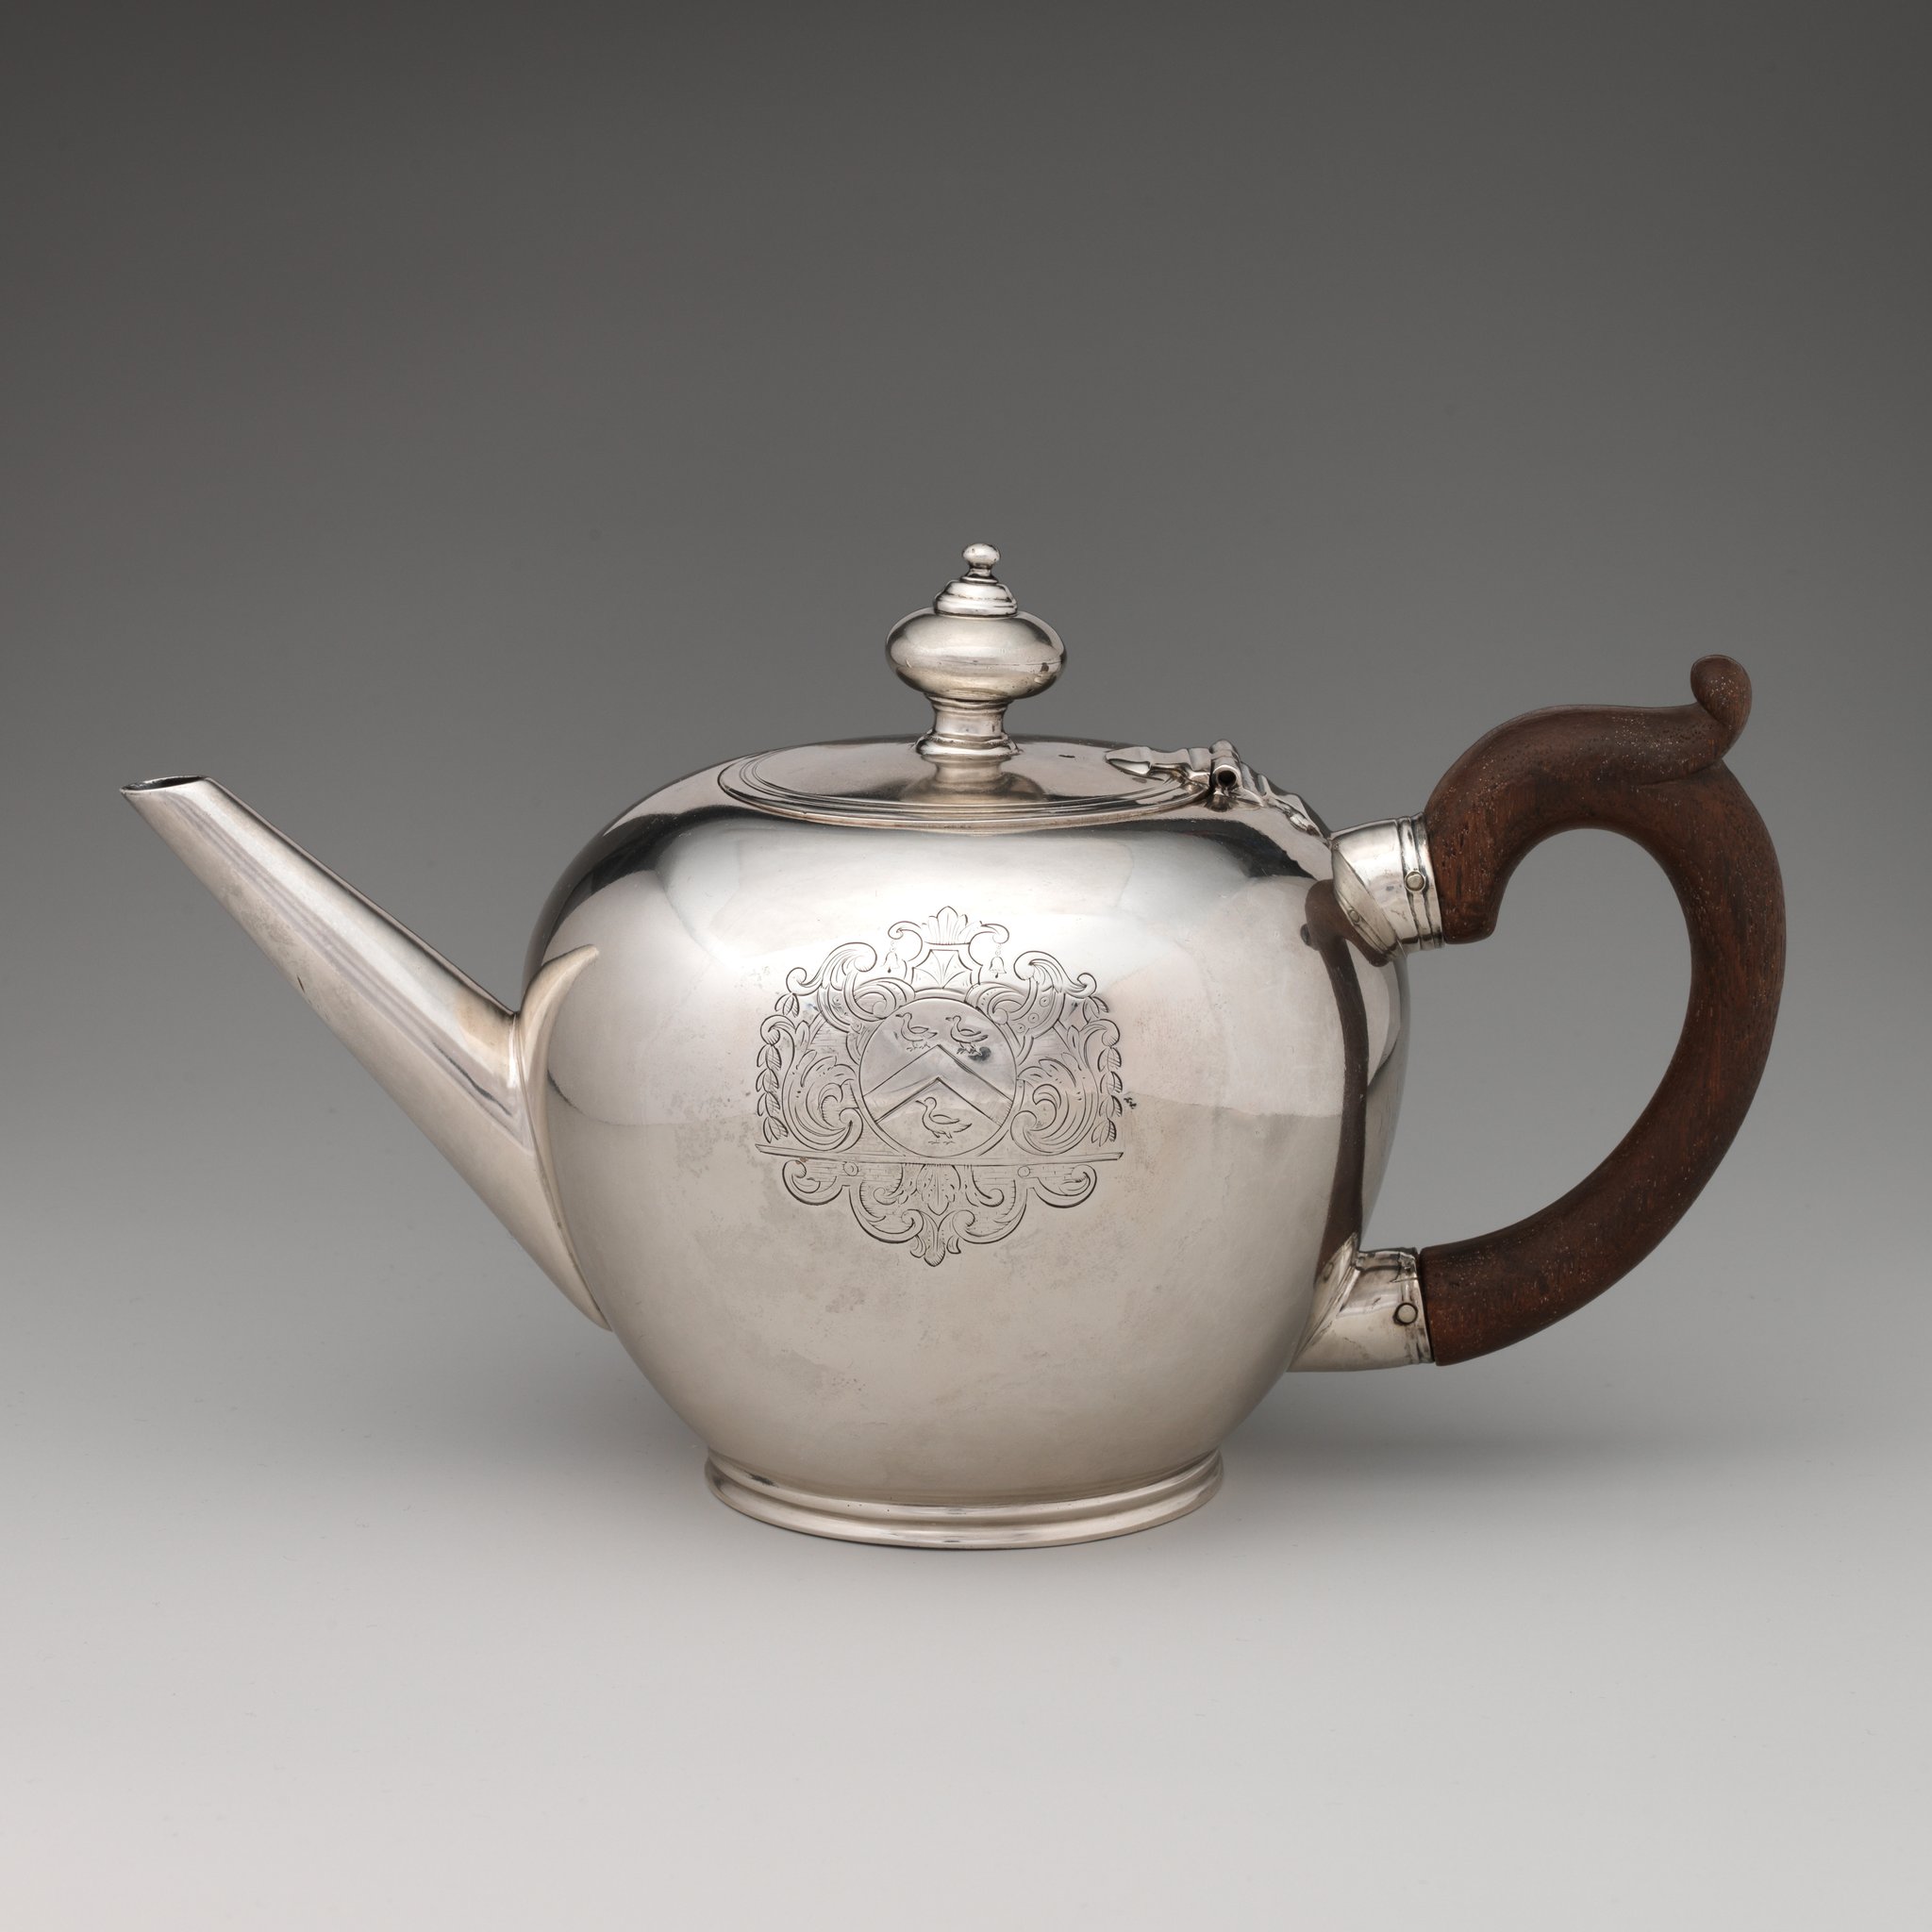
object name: teapot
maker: david king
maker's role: maker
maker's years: 1688-1738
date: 1723-1724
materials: silver, wood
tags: coat of arms